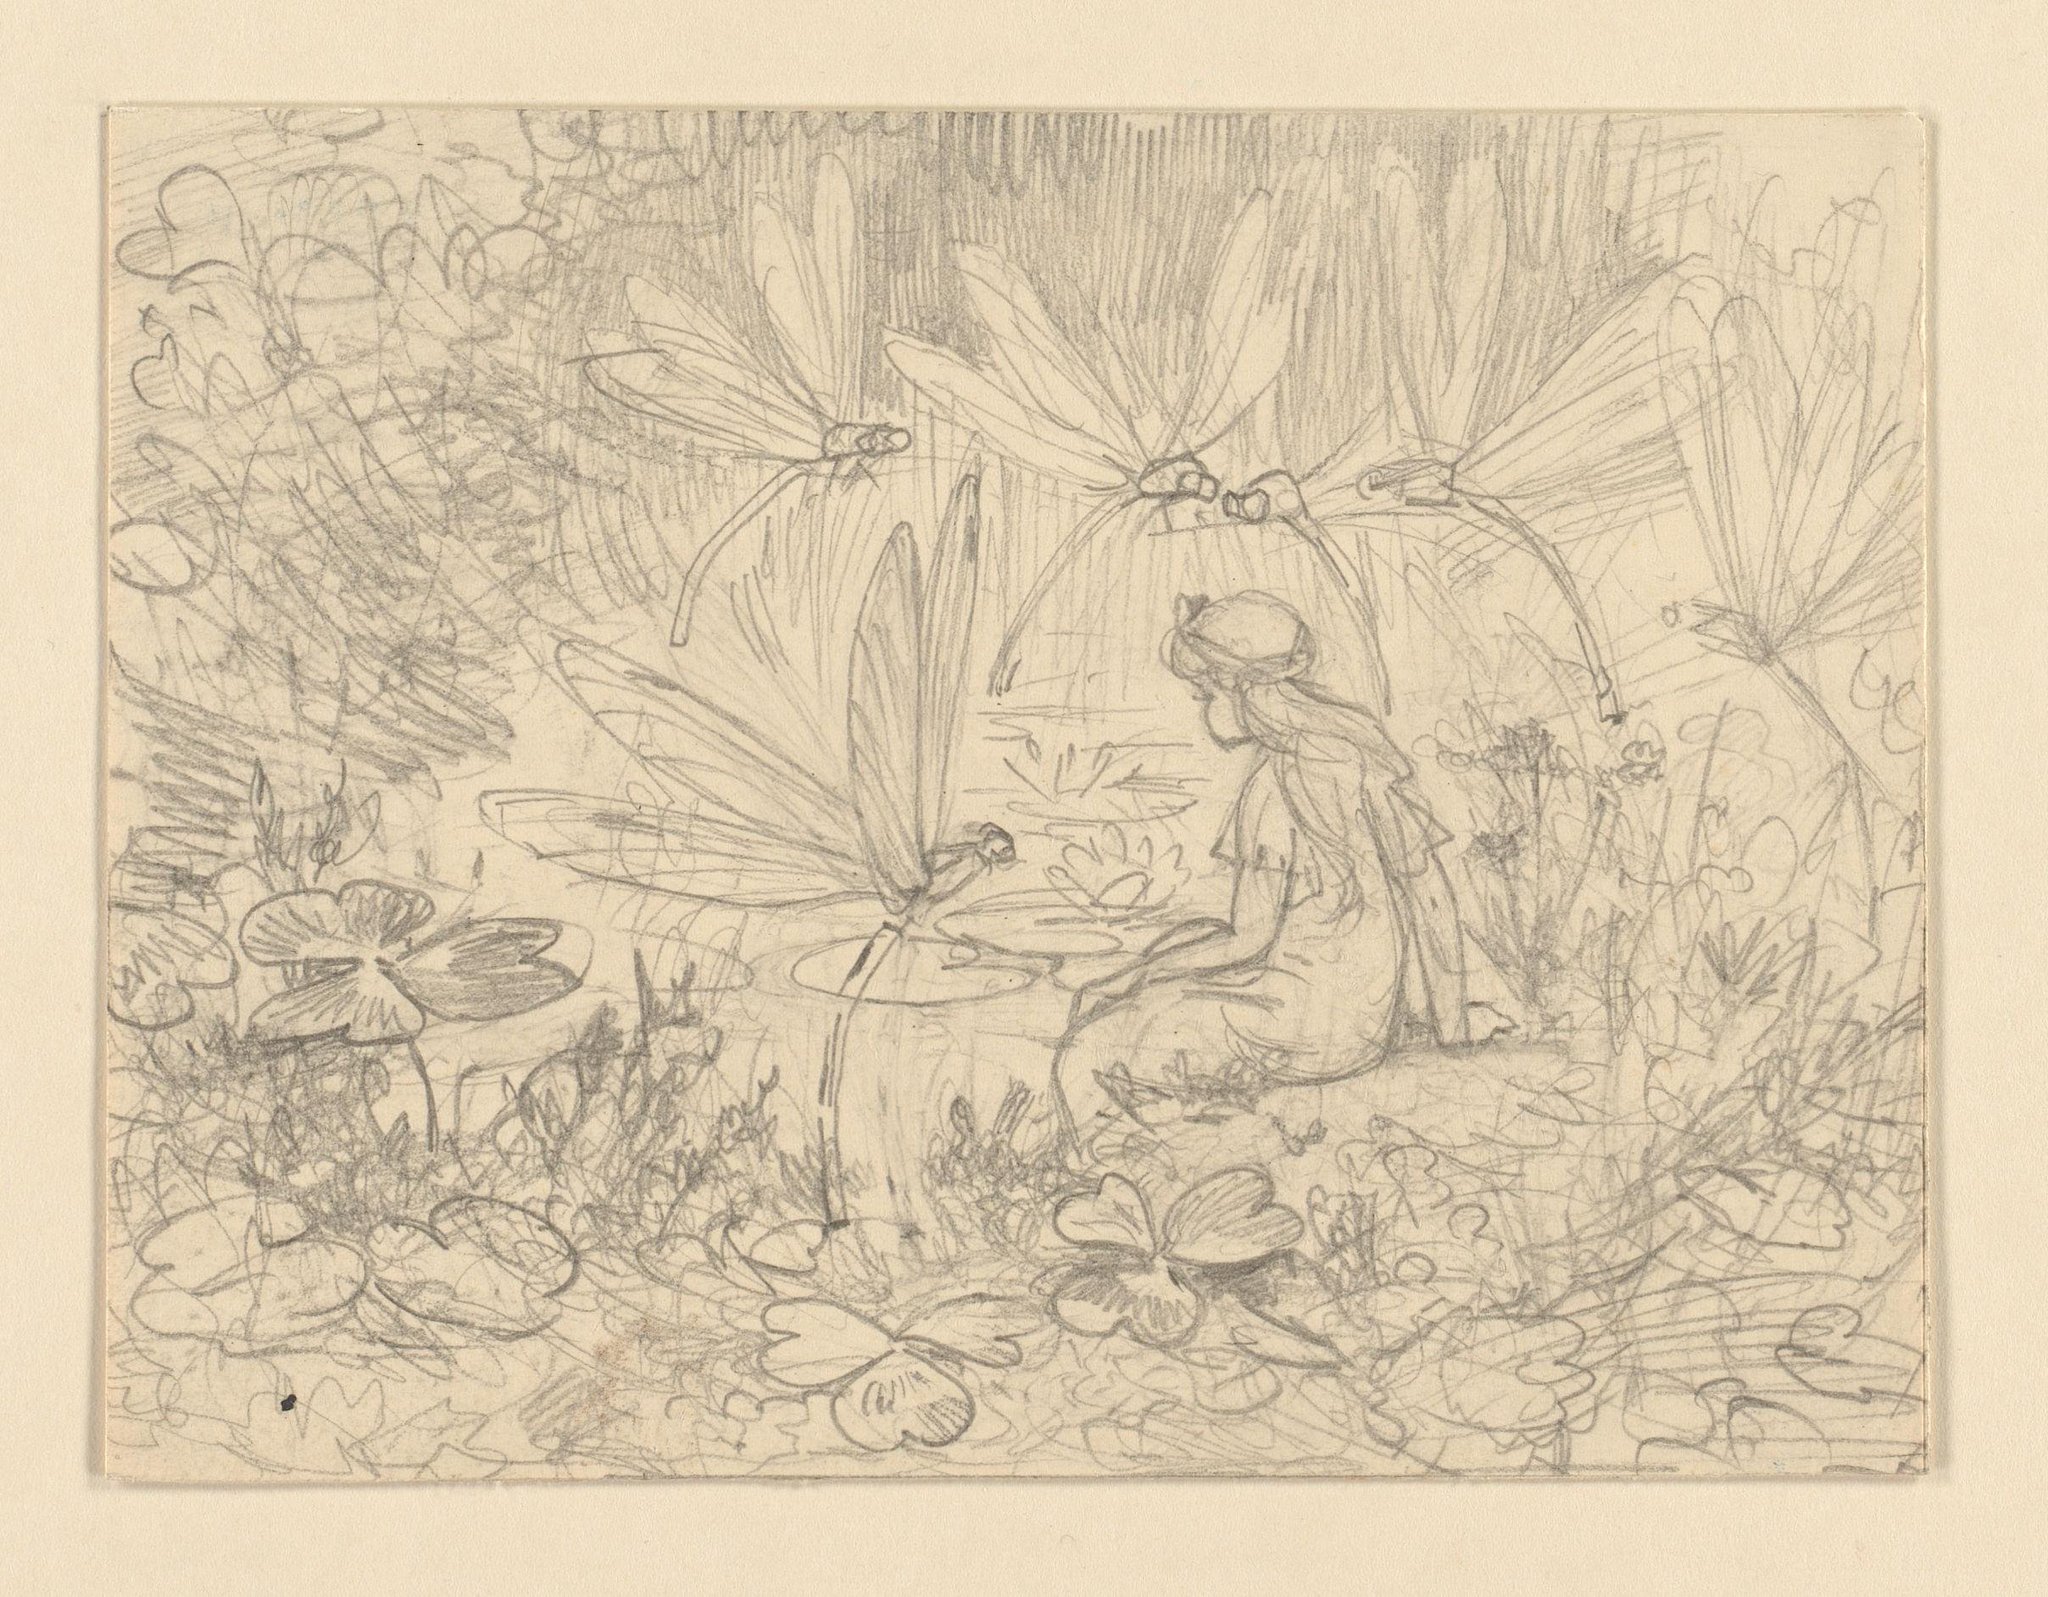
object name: boekillustratie ontwerp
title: De Grasprinses omringd door libellen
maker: edzard koning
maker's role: draughtsman, print maker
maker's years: 1869-1954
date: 1903-1931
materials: cardboard, pencil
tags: flowers, insects: dragon-fly, (koning, de grasprinses) specific works of literature (with author, title), princess, tales and fairy tales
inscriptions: number: ‘5.’, collector's mark: Lugt 2228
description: Ontwerp voor het niet uitgegeven sprookje: Koning, Edzard. De Grasprinses. Bussum: C.A.J. van Dishoeck, s.a.